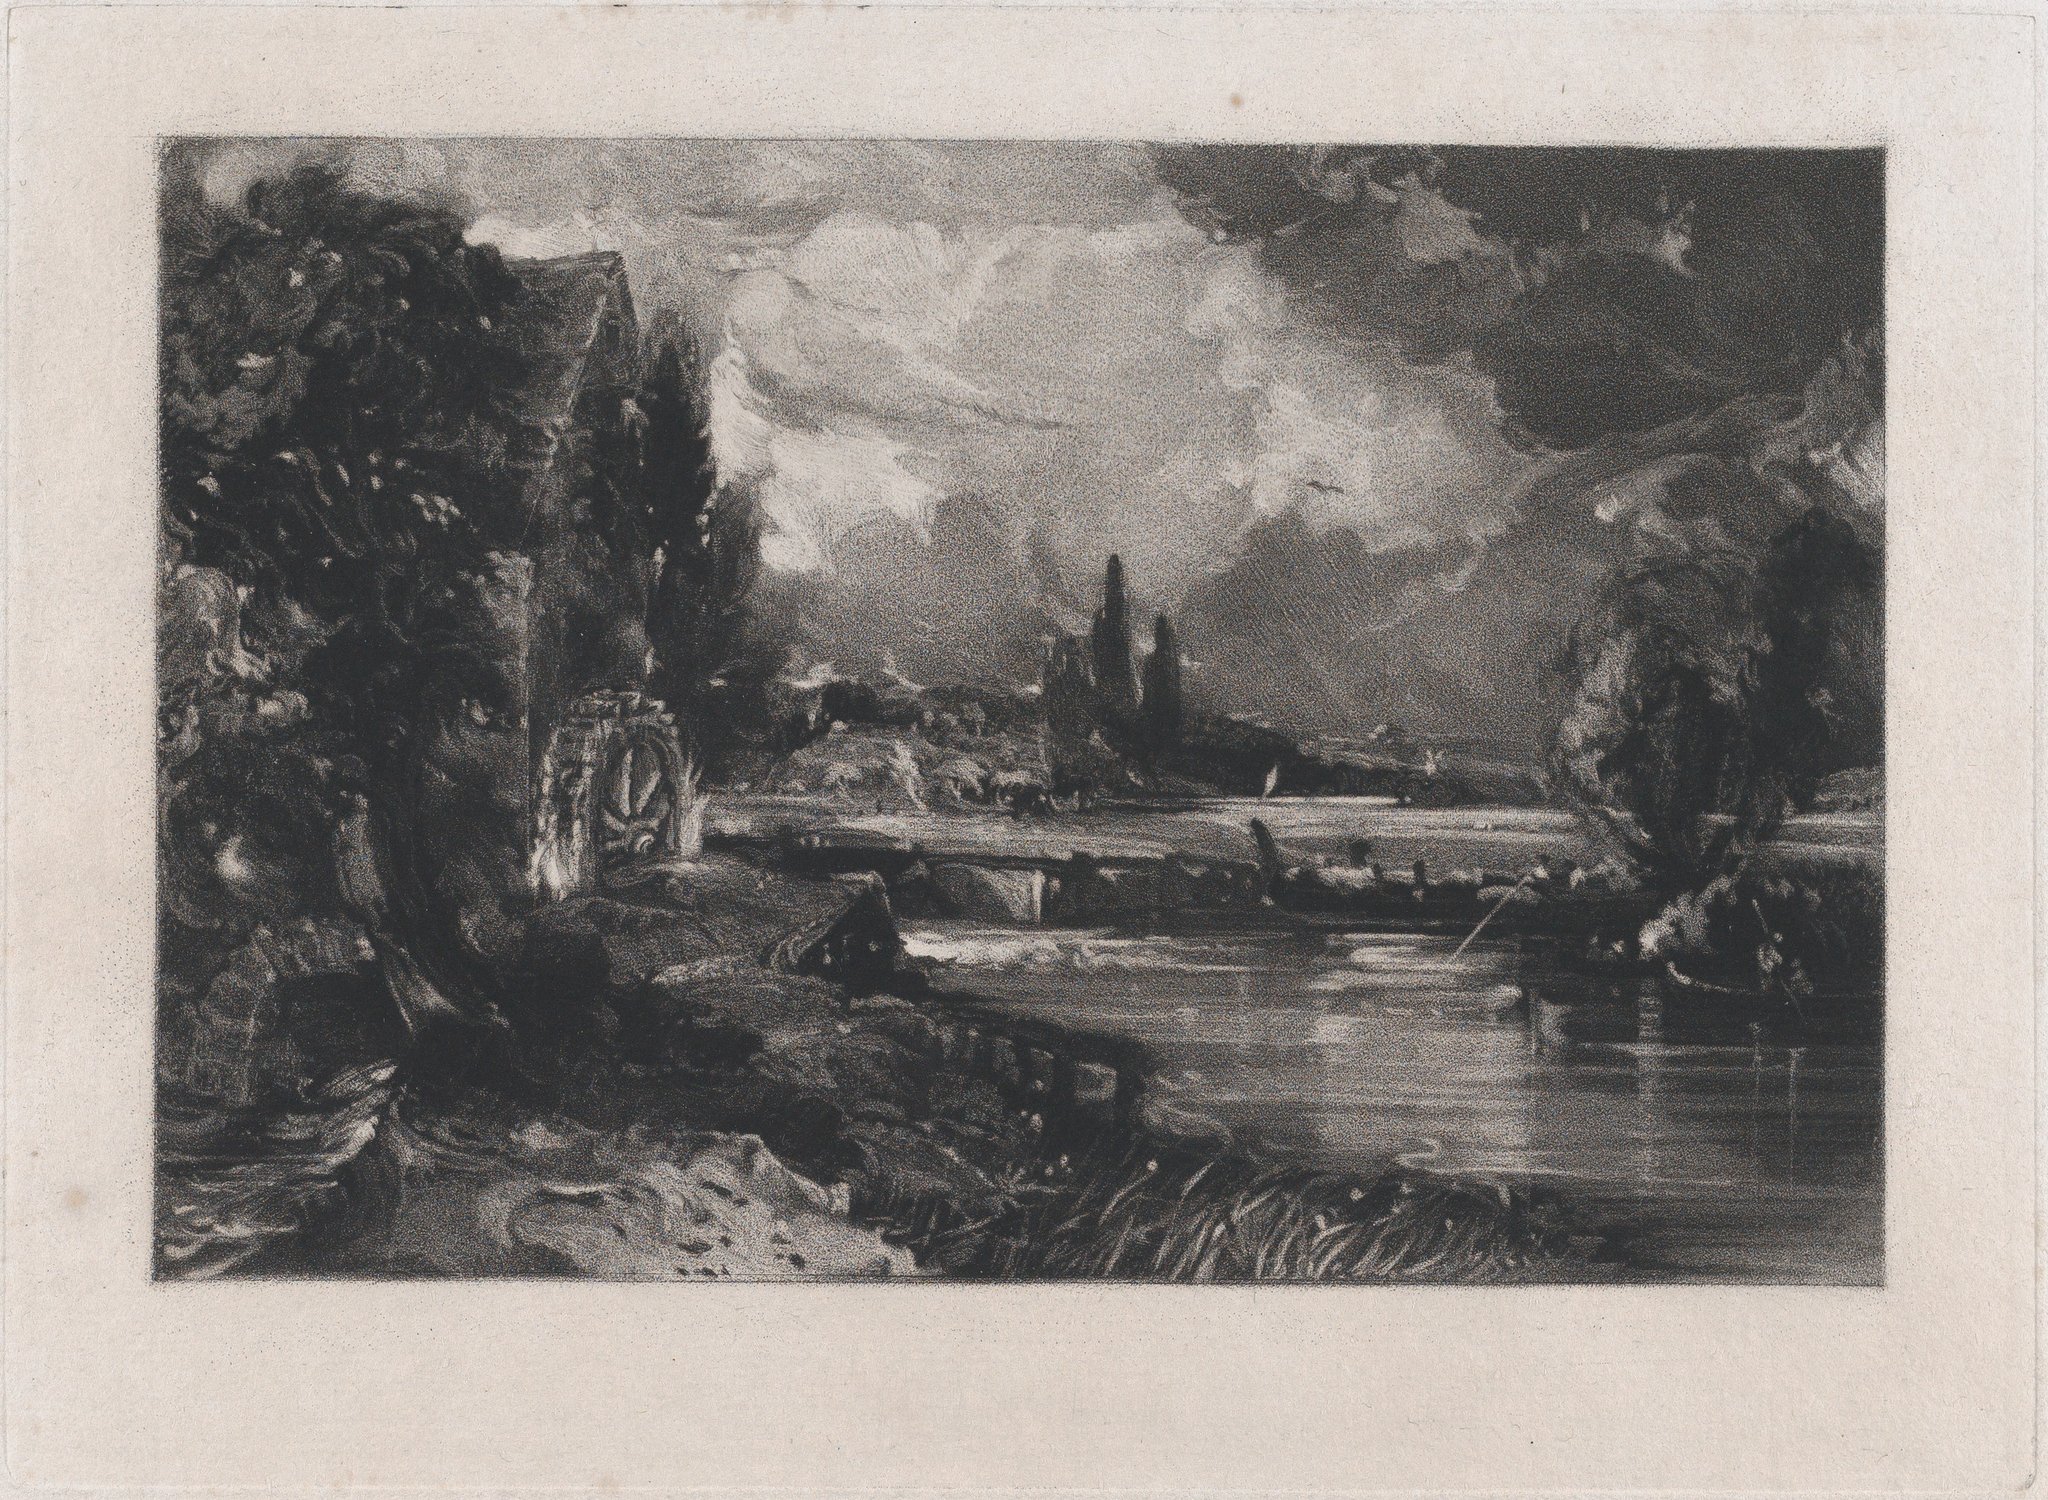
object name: print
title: A Mill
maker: david lucas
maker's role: artist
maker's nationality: british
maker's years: 1802-1881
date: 1829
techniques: mezzotint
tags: watermills,landscapes